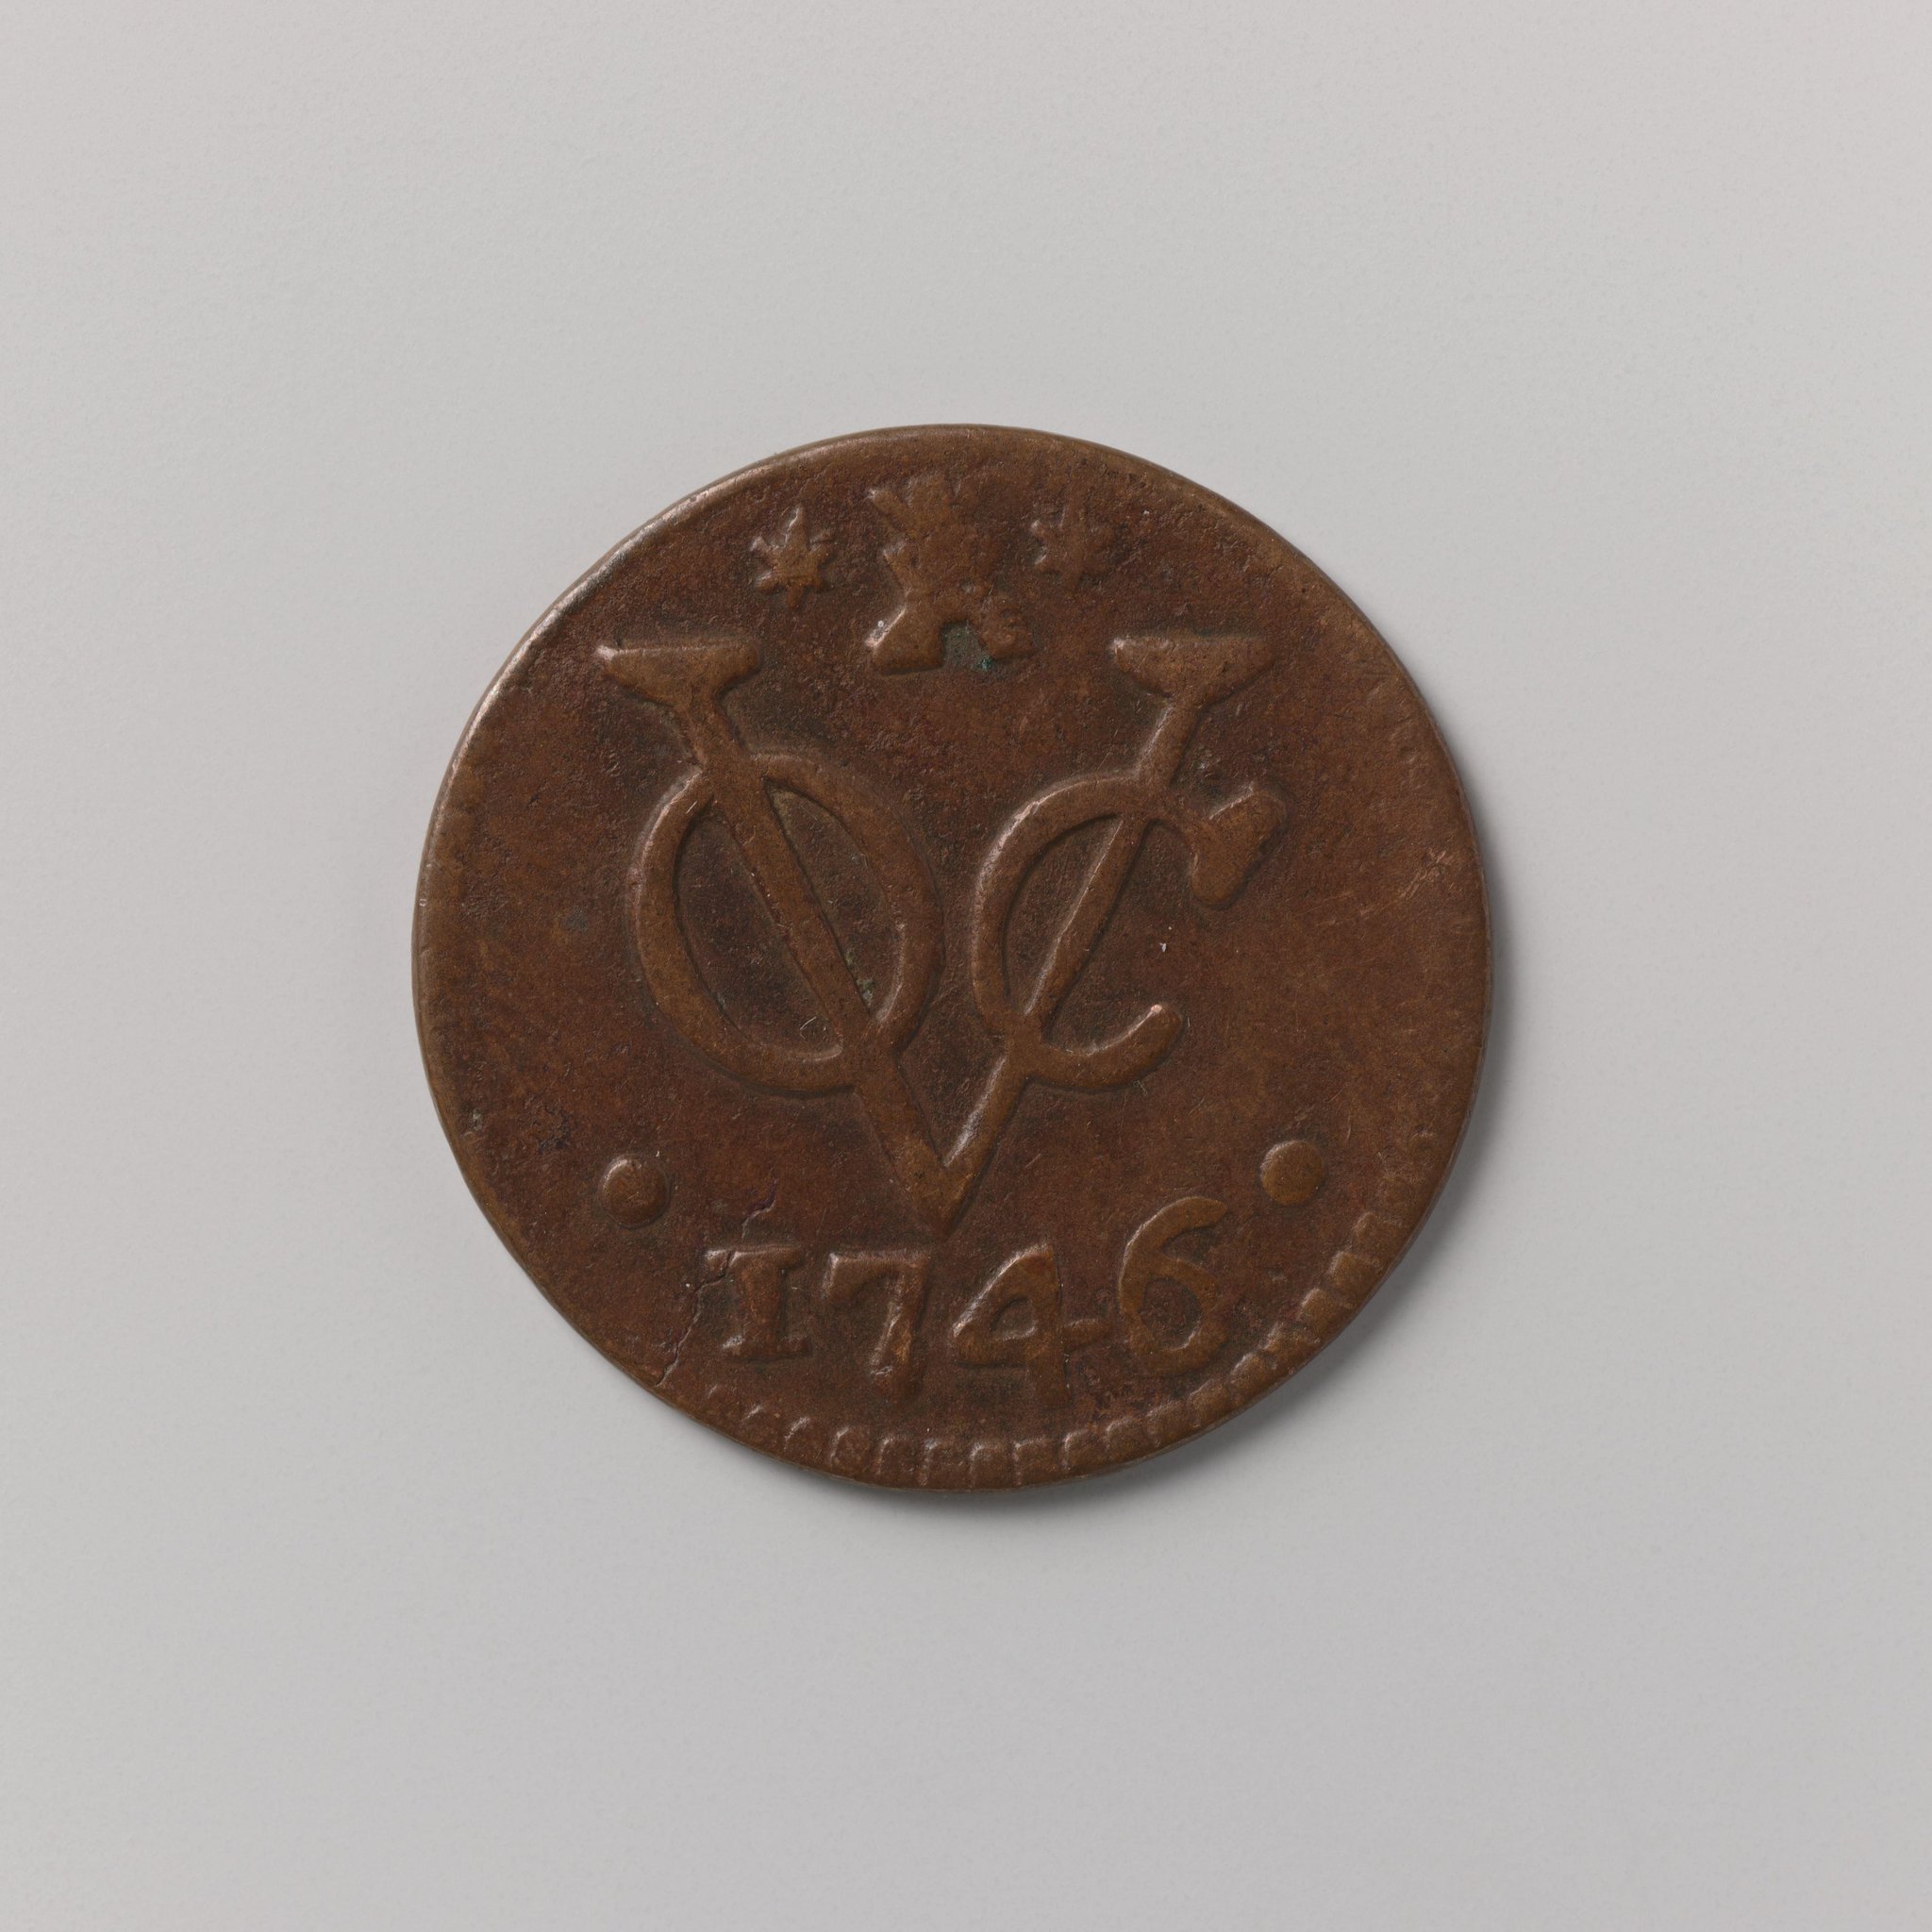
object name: coin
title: VOC, duit Zeeland, 1746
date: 1746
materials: copper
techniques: striking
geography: middelburg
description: Koperen munt. Voorzijde: gekroond wapenschild van Zeeland. Keerzijde: monogram van de VOC, waarboven muntteken en waaronder jaartal. Gladde rand.